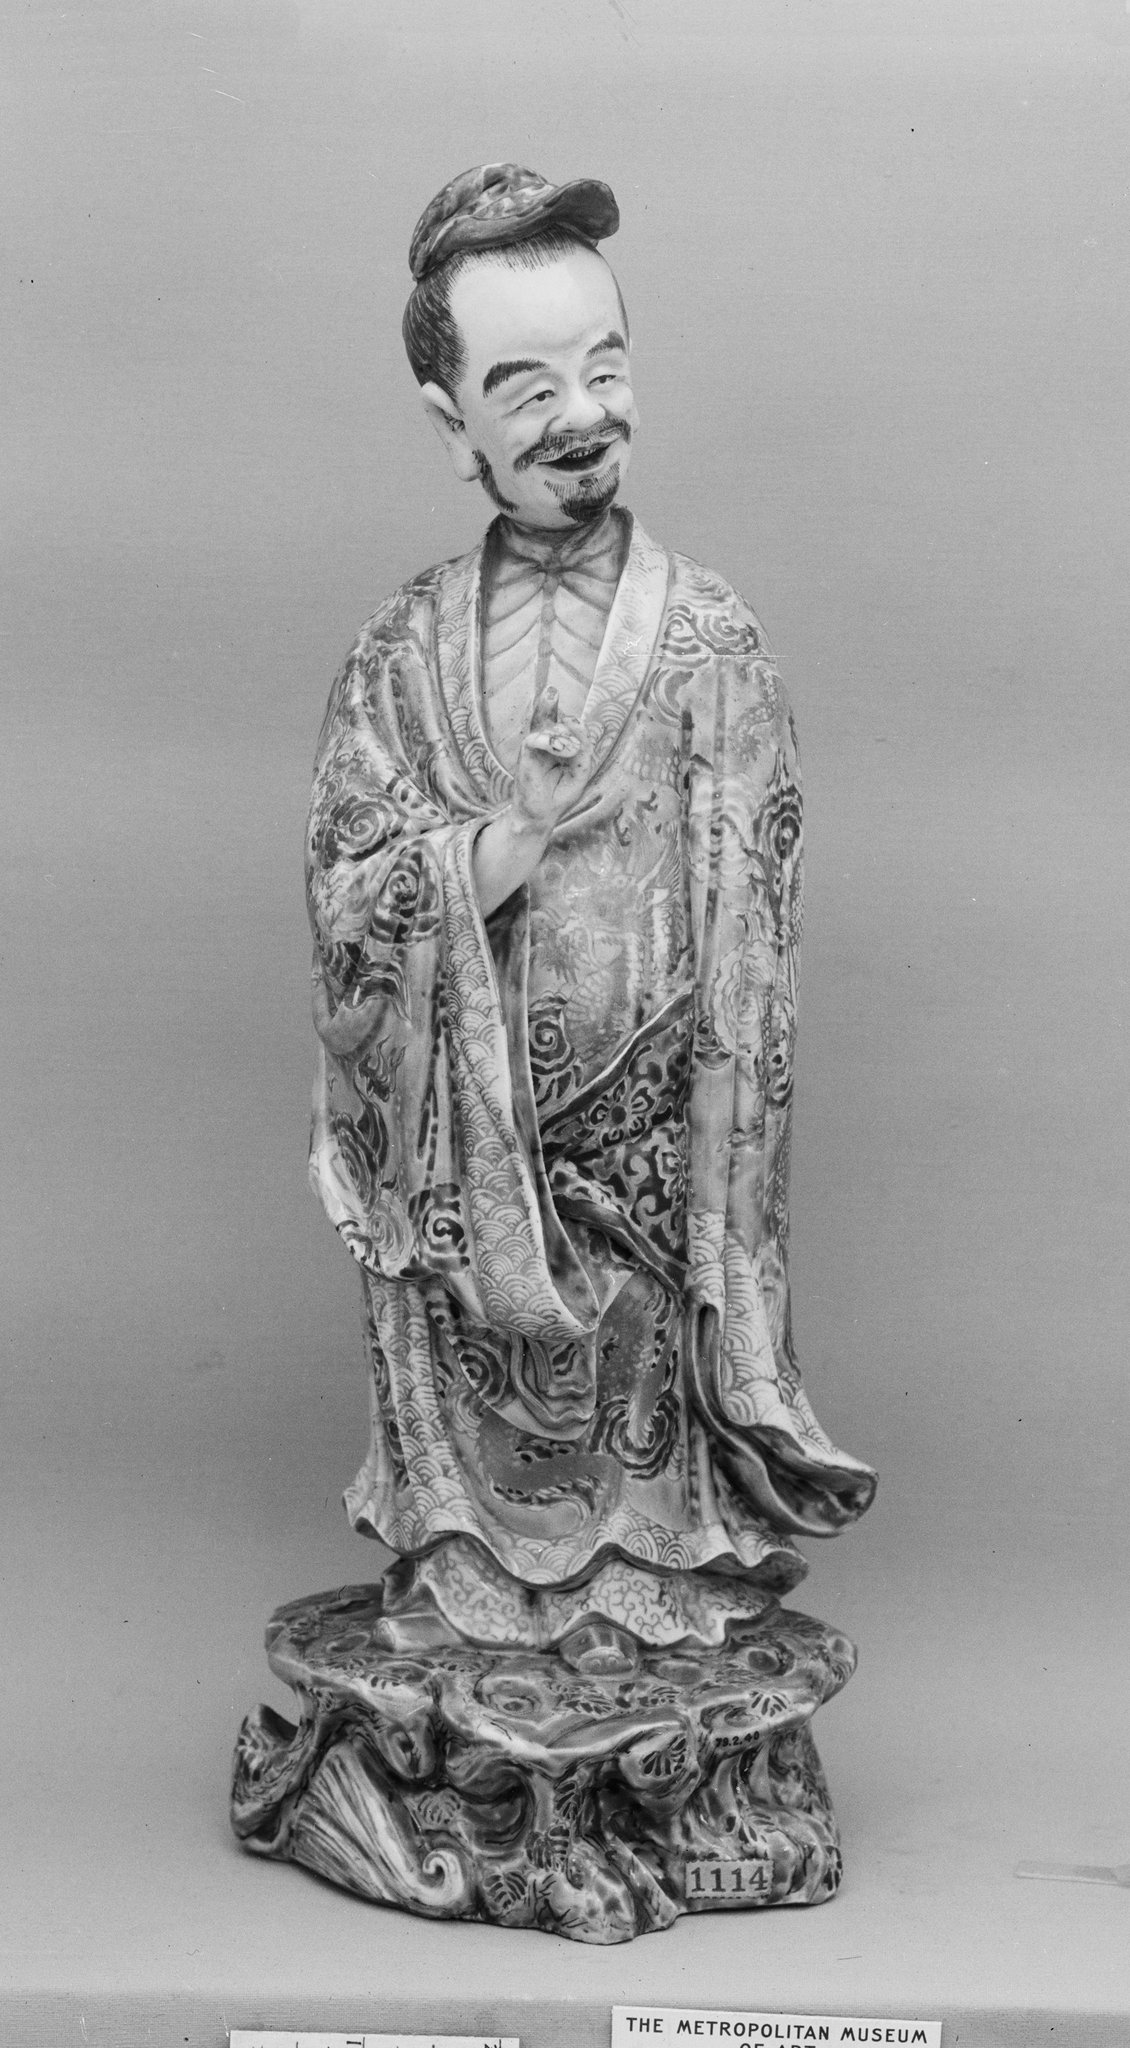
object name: figure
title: Figure of a Man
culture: japanese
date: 1801-1900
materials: enamel, gold, iron, porcelain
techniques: polychrome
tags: men